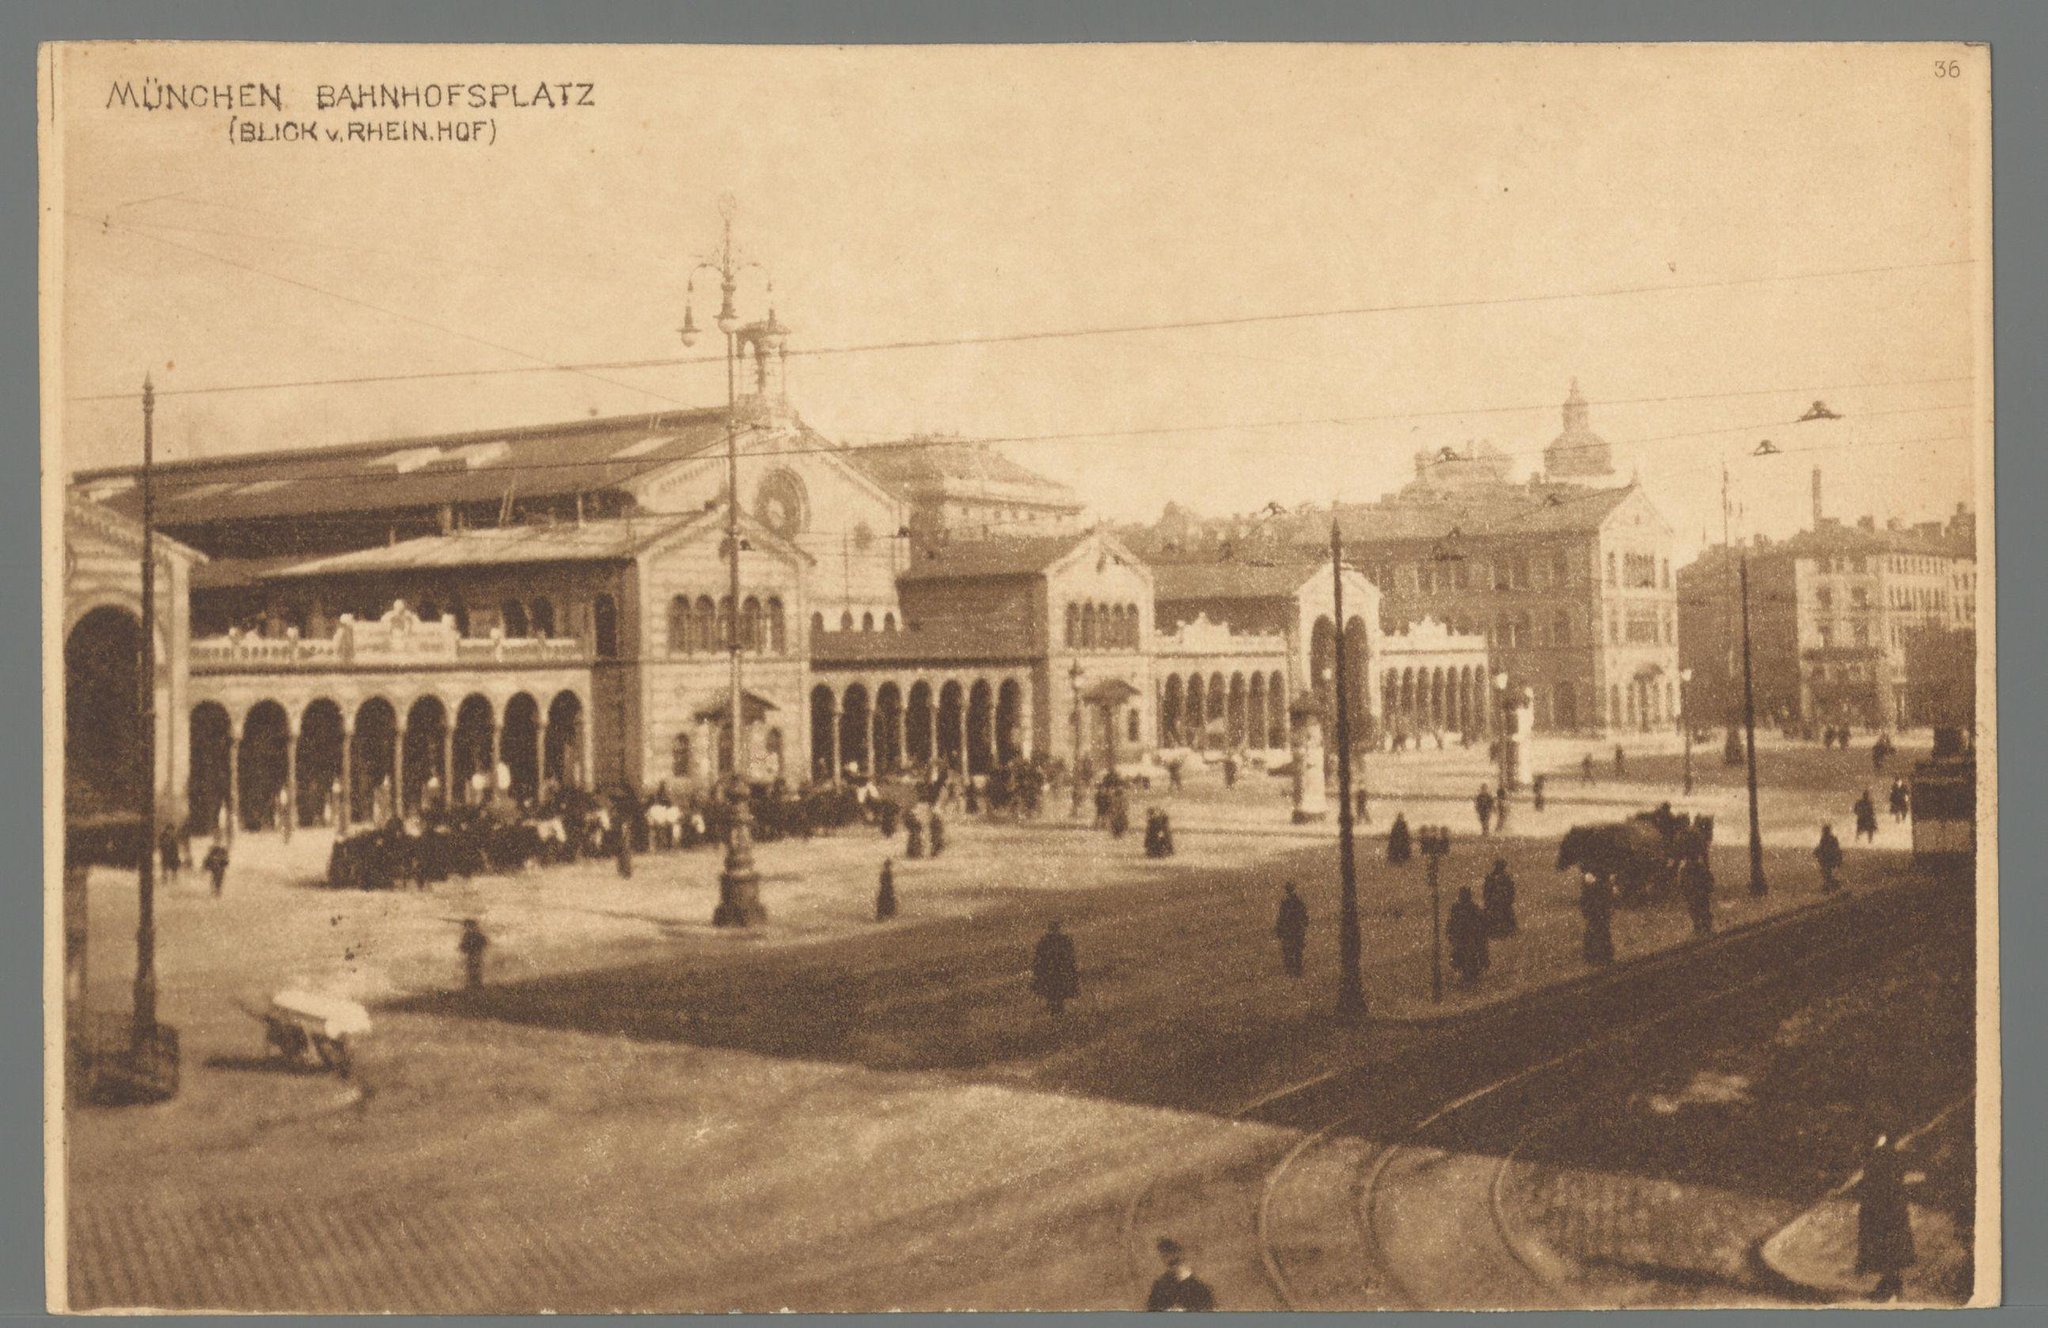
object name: photomechanical print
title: München Bahnhofsplatz (blick v. Rhein. Hof)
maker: f. beck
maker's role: printer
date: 1905-1930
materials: cardboard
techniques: photoaquatint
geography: munich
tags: square, place, circus, etc., station; shelter (railway, tramway)